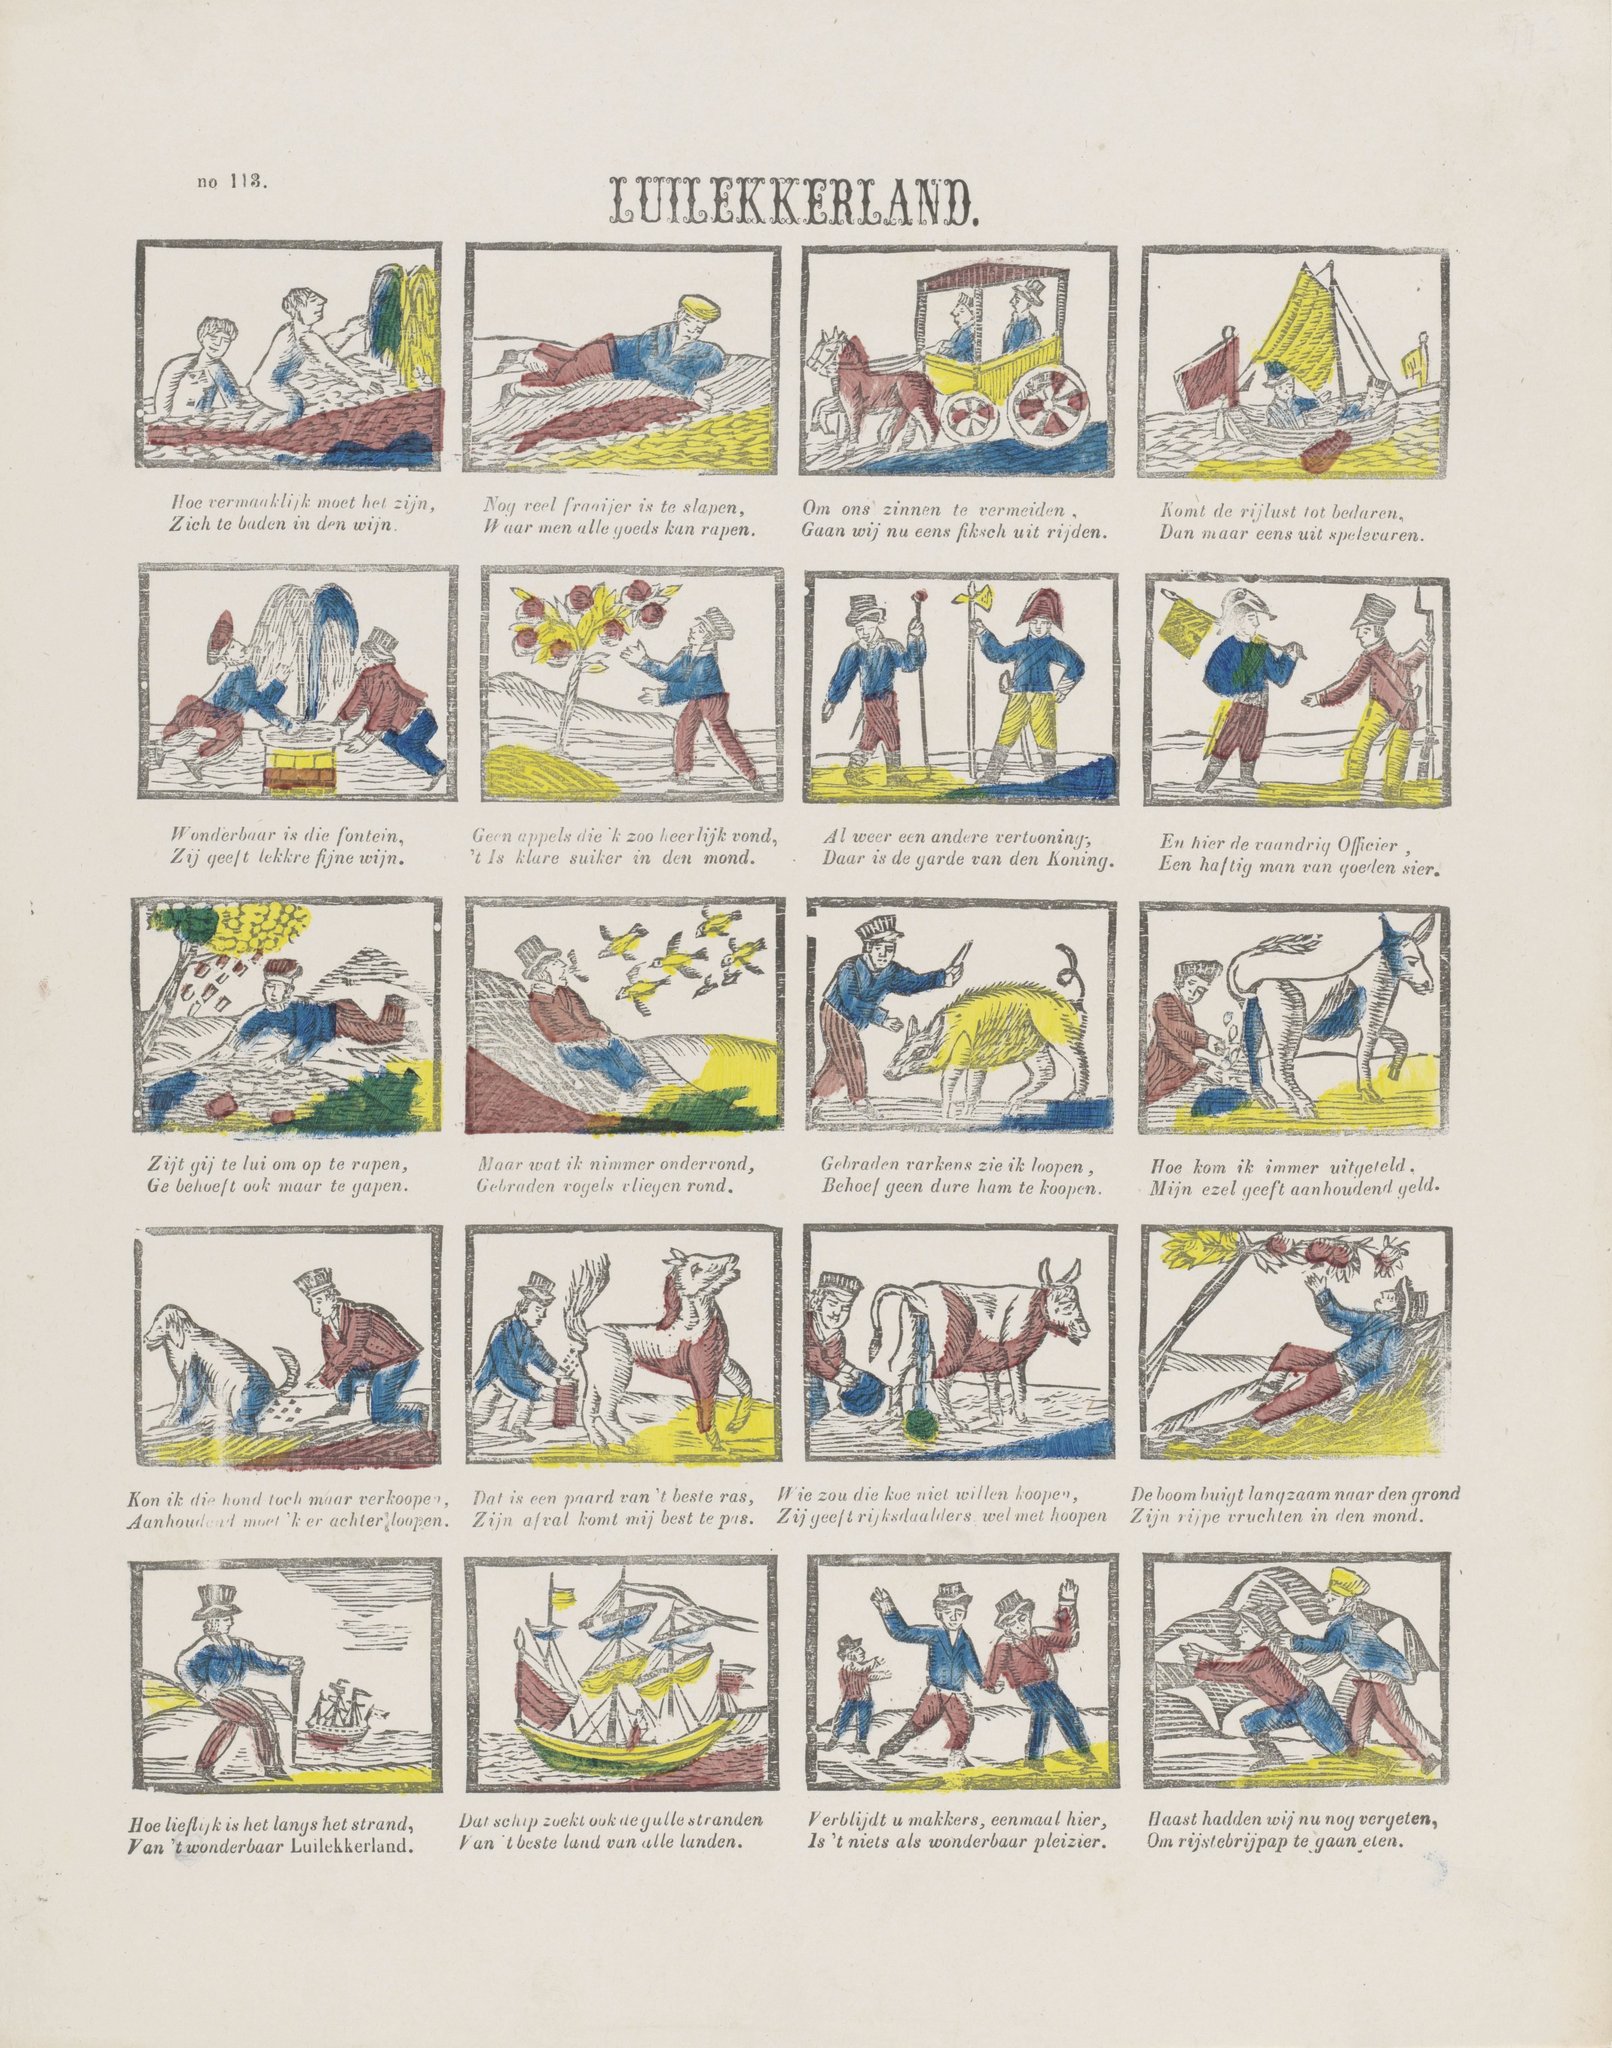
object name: popular print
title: Luilekkerland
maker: Anonymous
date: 1848-1881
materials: paper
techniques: colour, letterpress printing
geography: den bosch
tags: land of cockaigne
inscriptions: collector's mark: Lugt 2760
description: Blad met 20 voorstellingen van het Luilekkerland. Onder elke voorstelling een tweeregelig vers. Genummerd linksboven: no 113.